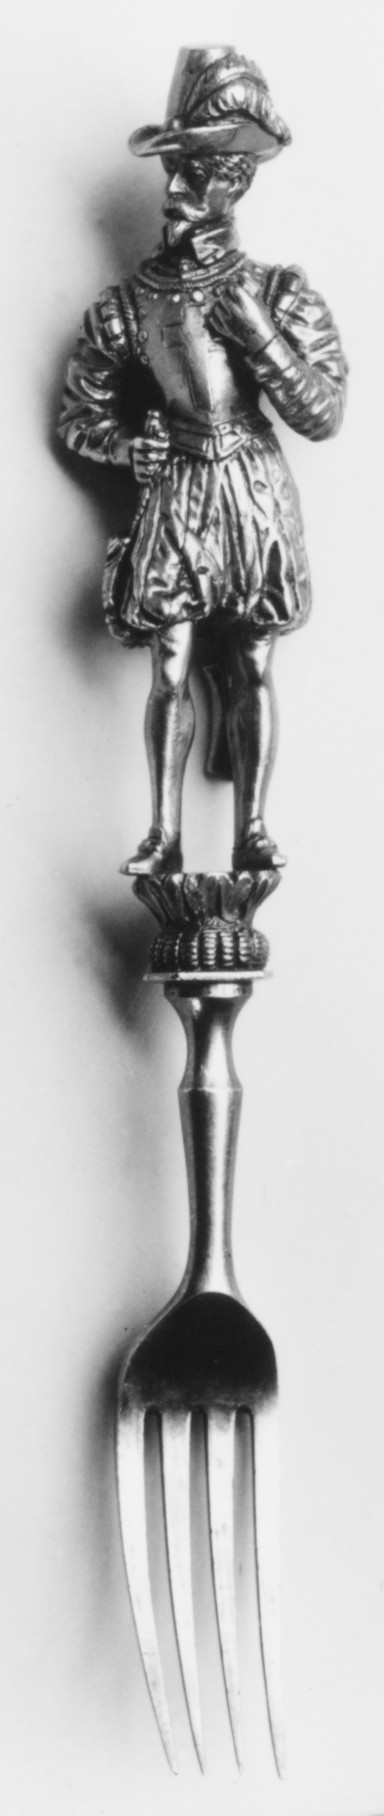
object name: fork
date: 1801-1900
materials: silver gilt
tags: men